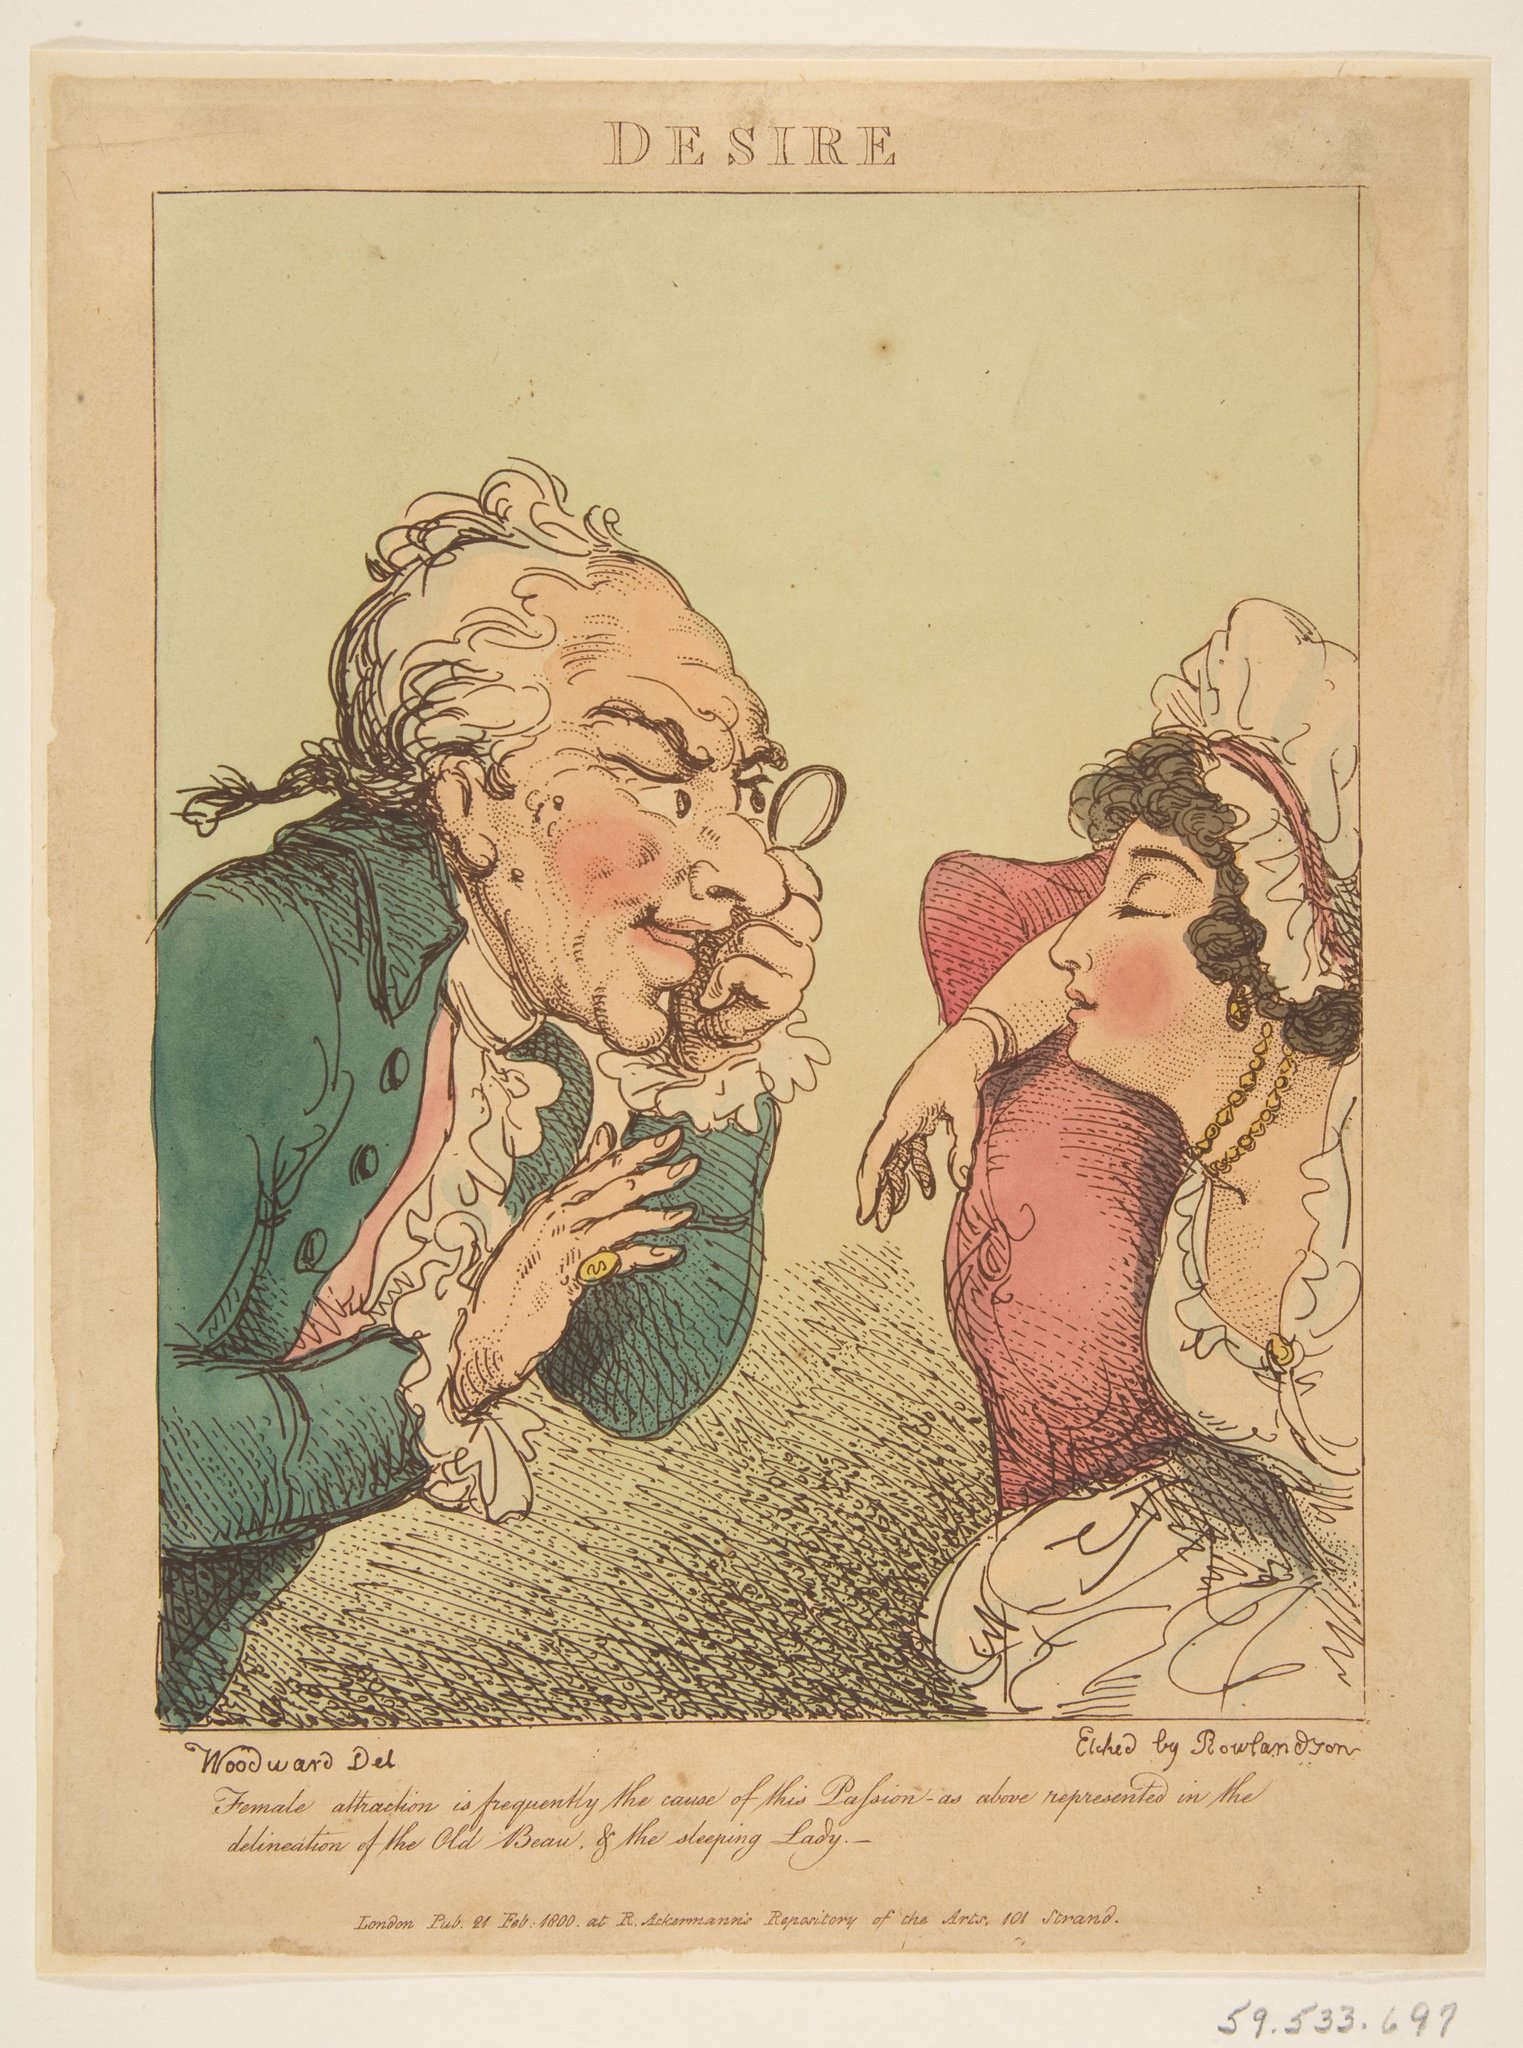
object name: print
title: Desire (Le Brun Travested, or Caricatures of the Passions)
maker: thomas rowlandson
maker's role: artist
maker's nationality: british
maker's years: 1757-1827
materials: ink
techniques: etching, printing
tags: satire,men,women